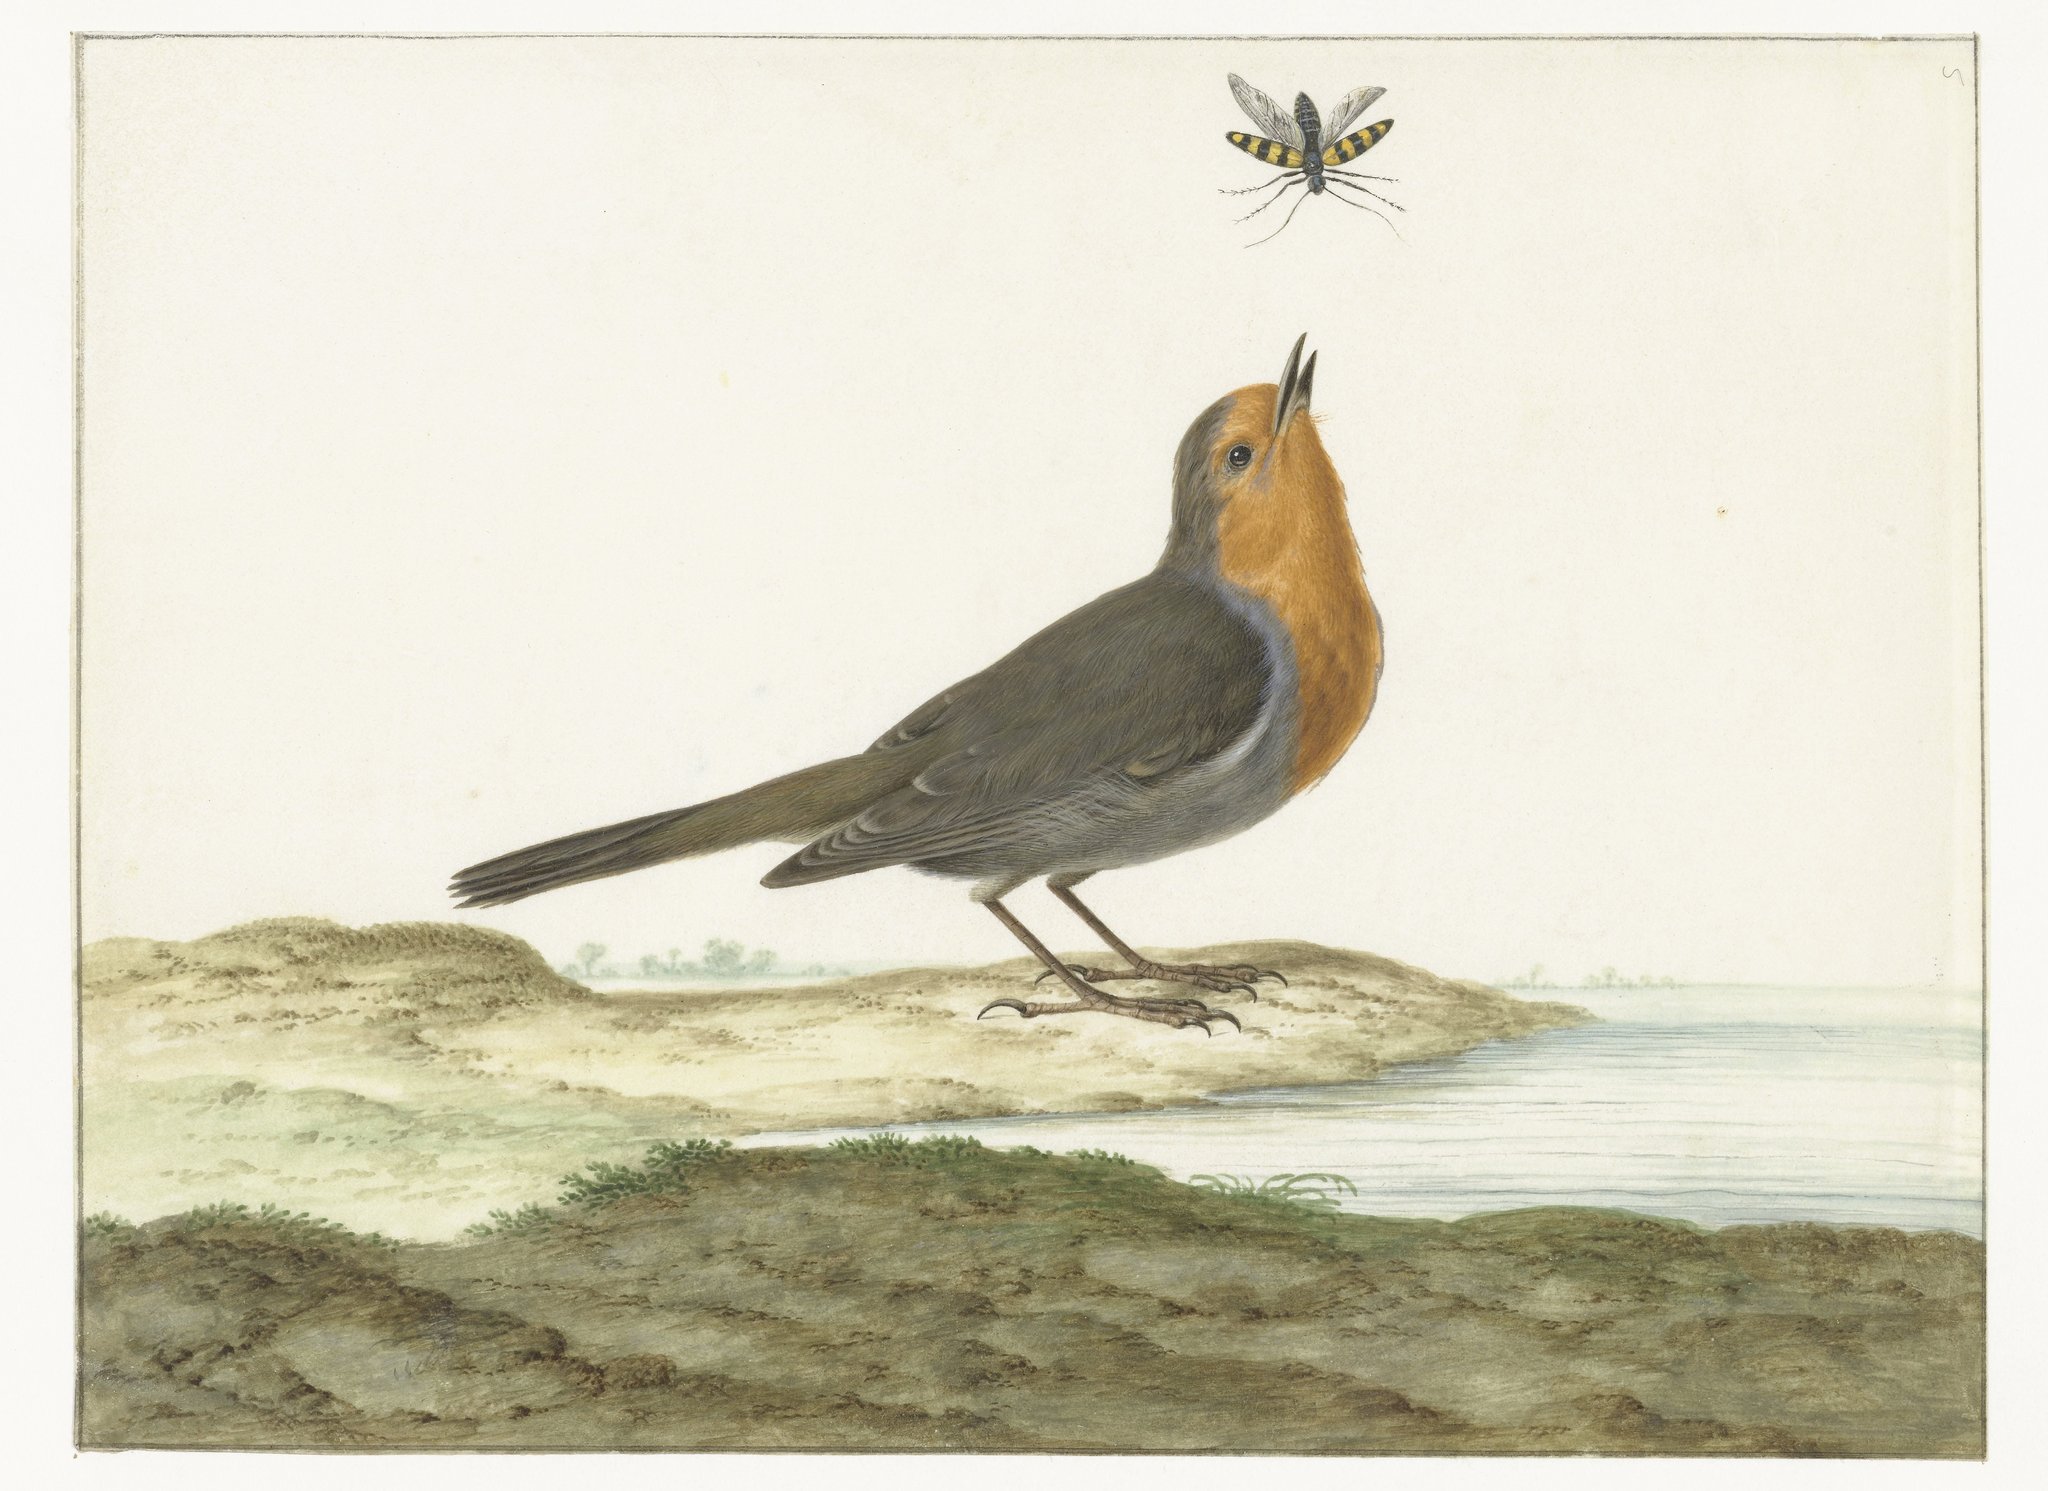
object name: watercolor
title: Roodborstje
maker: johannes bronkhorst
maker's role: draughtsman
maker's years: 1648-1727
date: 1658-1726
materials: parchment, watercolor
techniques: brush